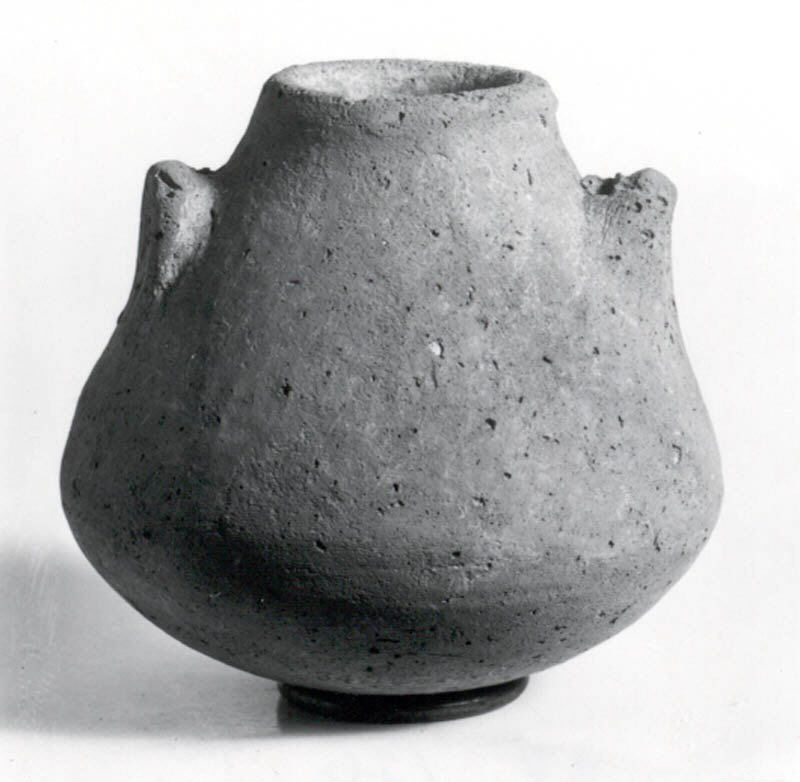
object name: jug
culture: israelite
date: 734-601 BCE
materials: ceramic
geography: levant